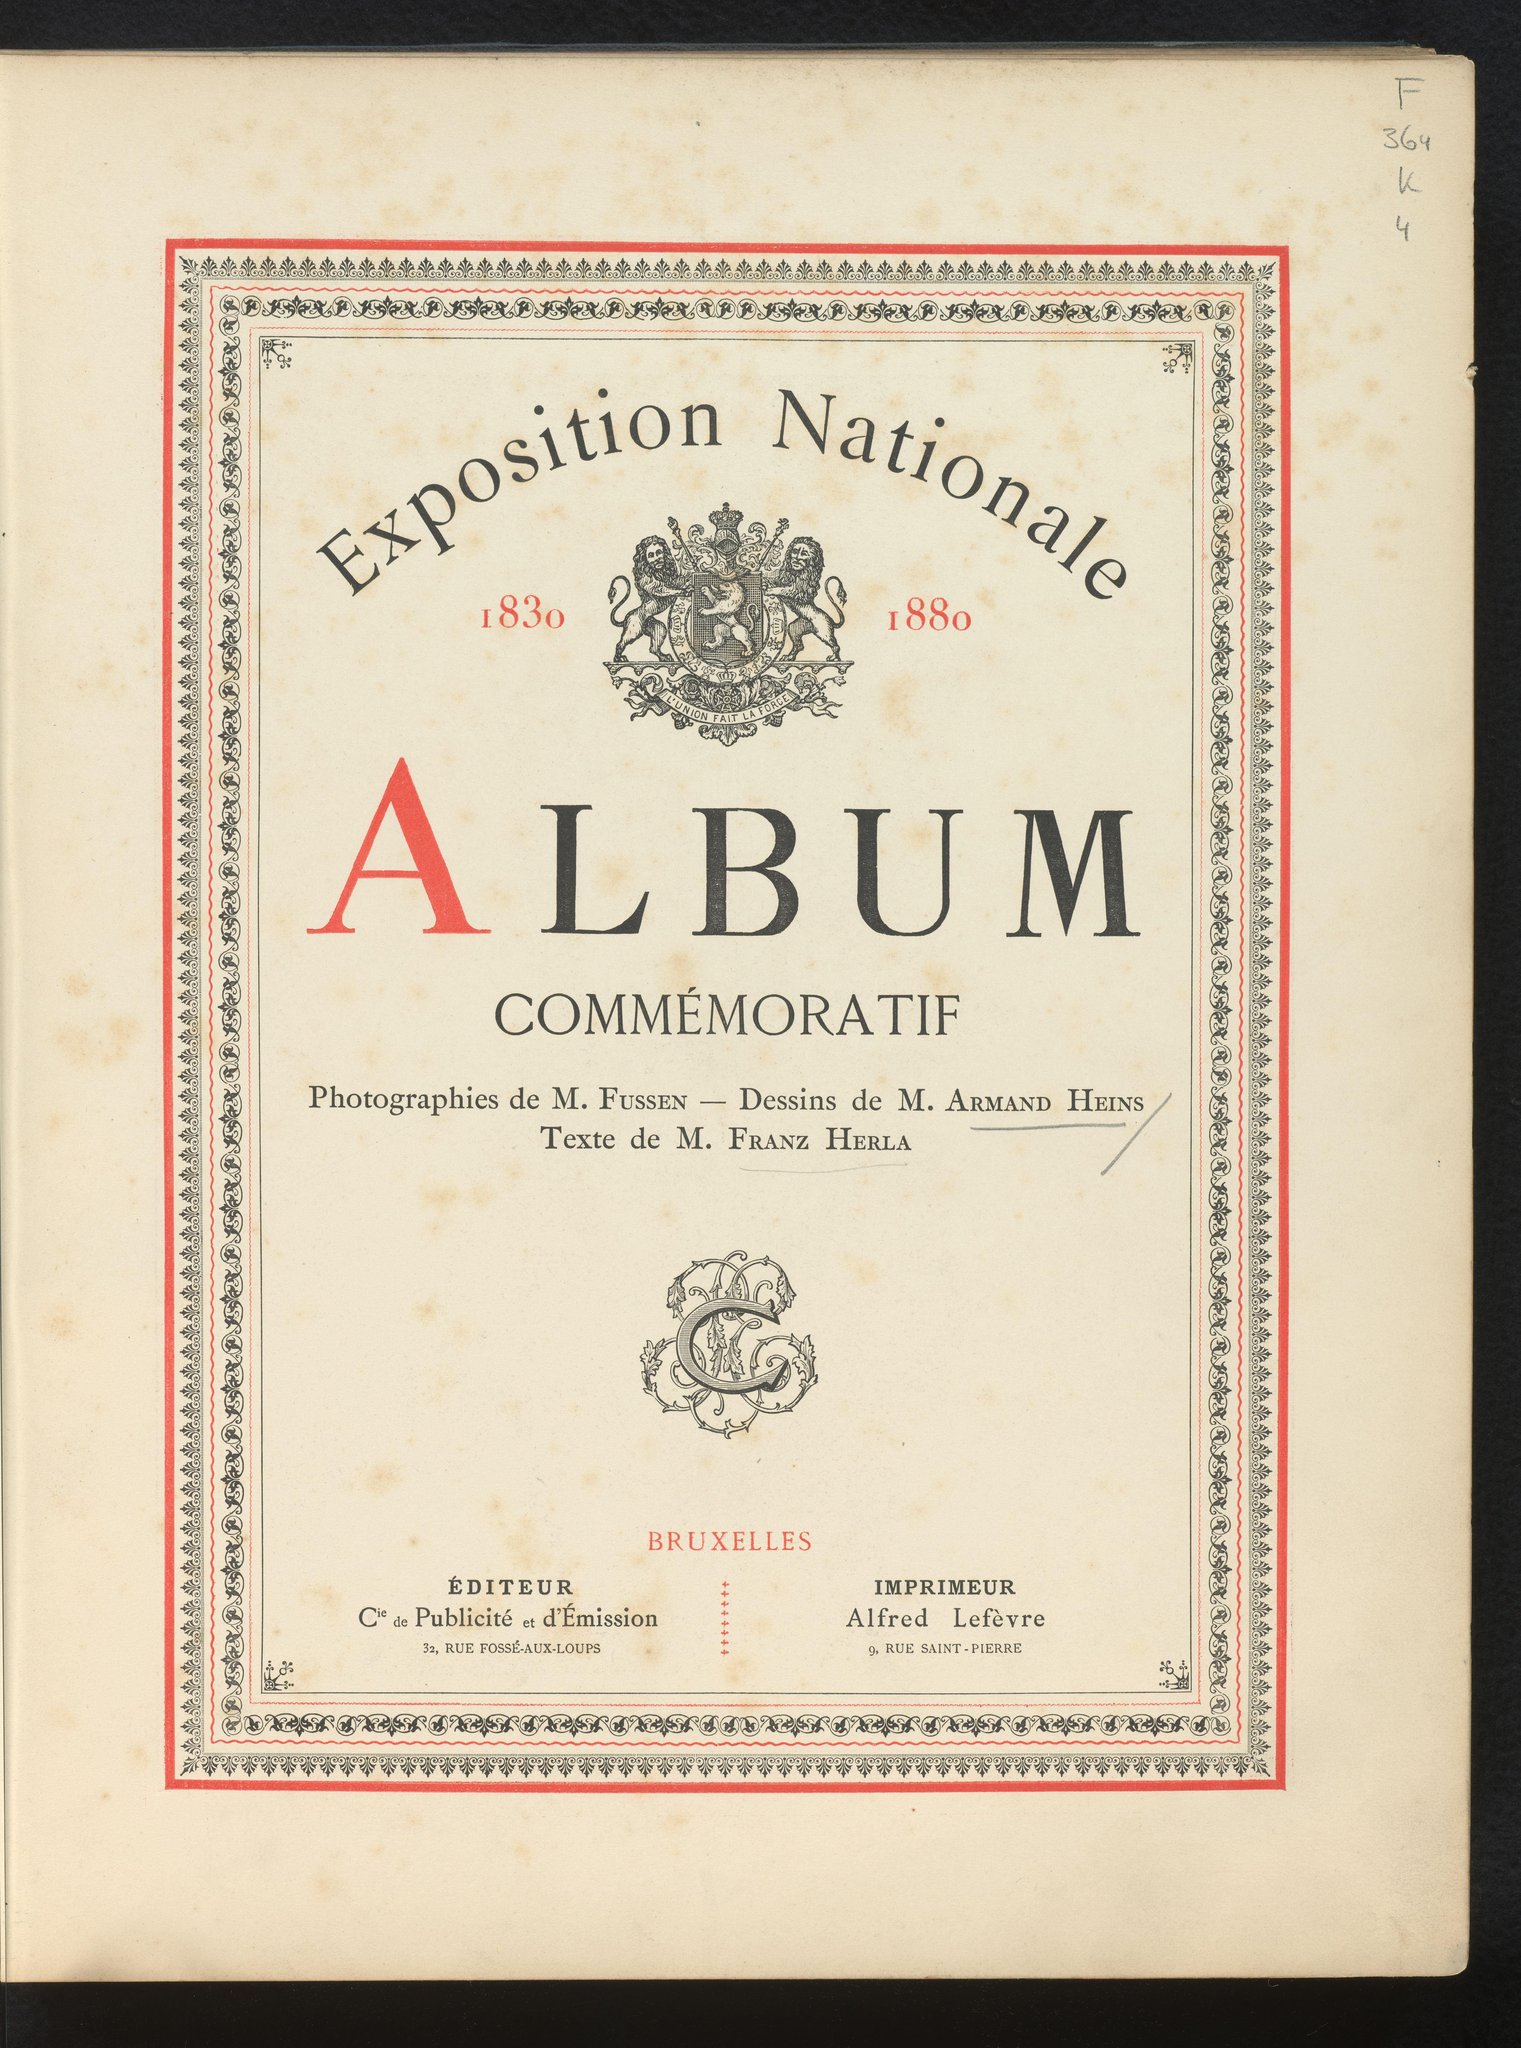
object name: book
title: Exposition nationale 1830-1880 : album commémoratif / photogr. de Fussen; dessins de Armand Heins; texte de Franz Herla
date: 1882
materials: cardboard, linen, paper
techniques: photograph, printing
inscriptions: annotation: ‘Heins/ 1881’, annotation: ‘dirty/ water. 23/1350’, bookplate: ‘EX/ SFJ/ LIBRIS’, date: ‘FEB 1983’